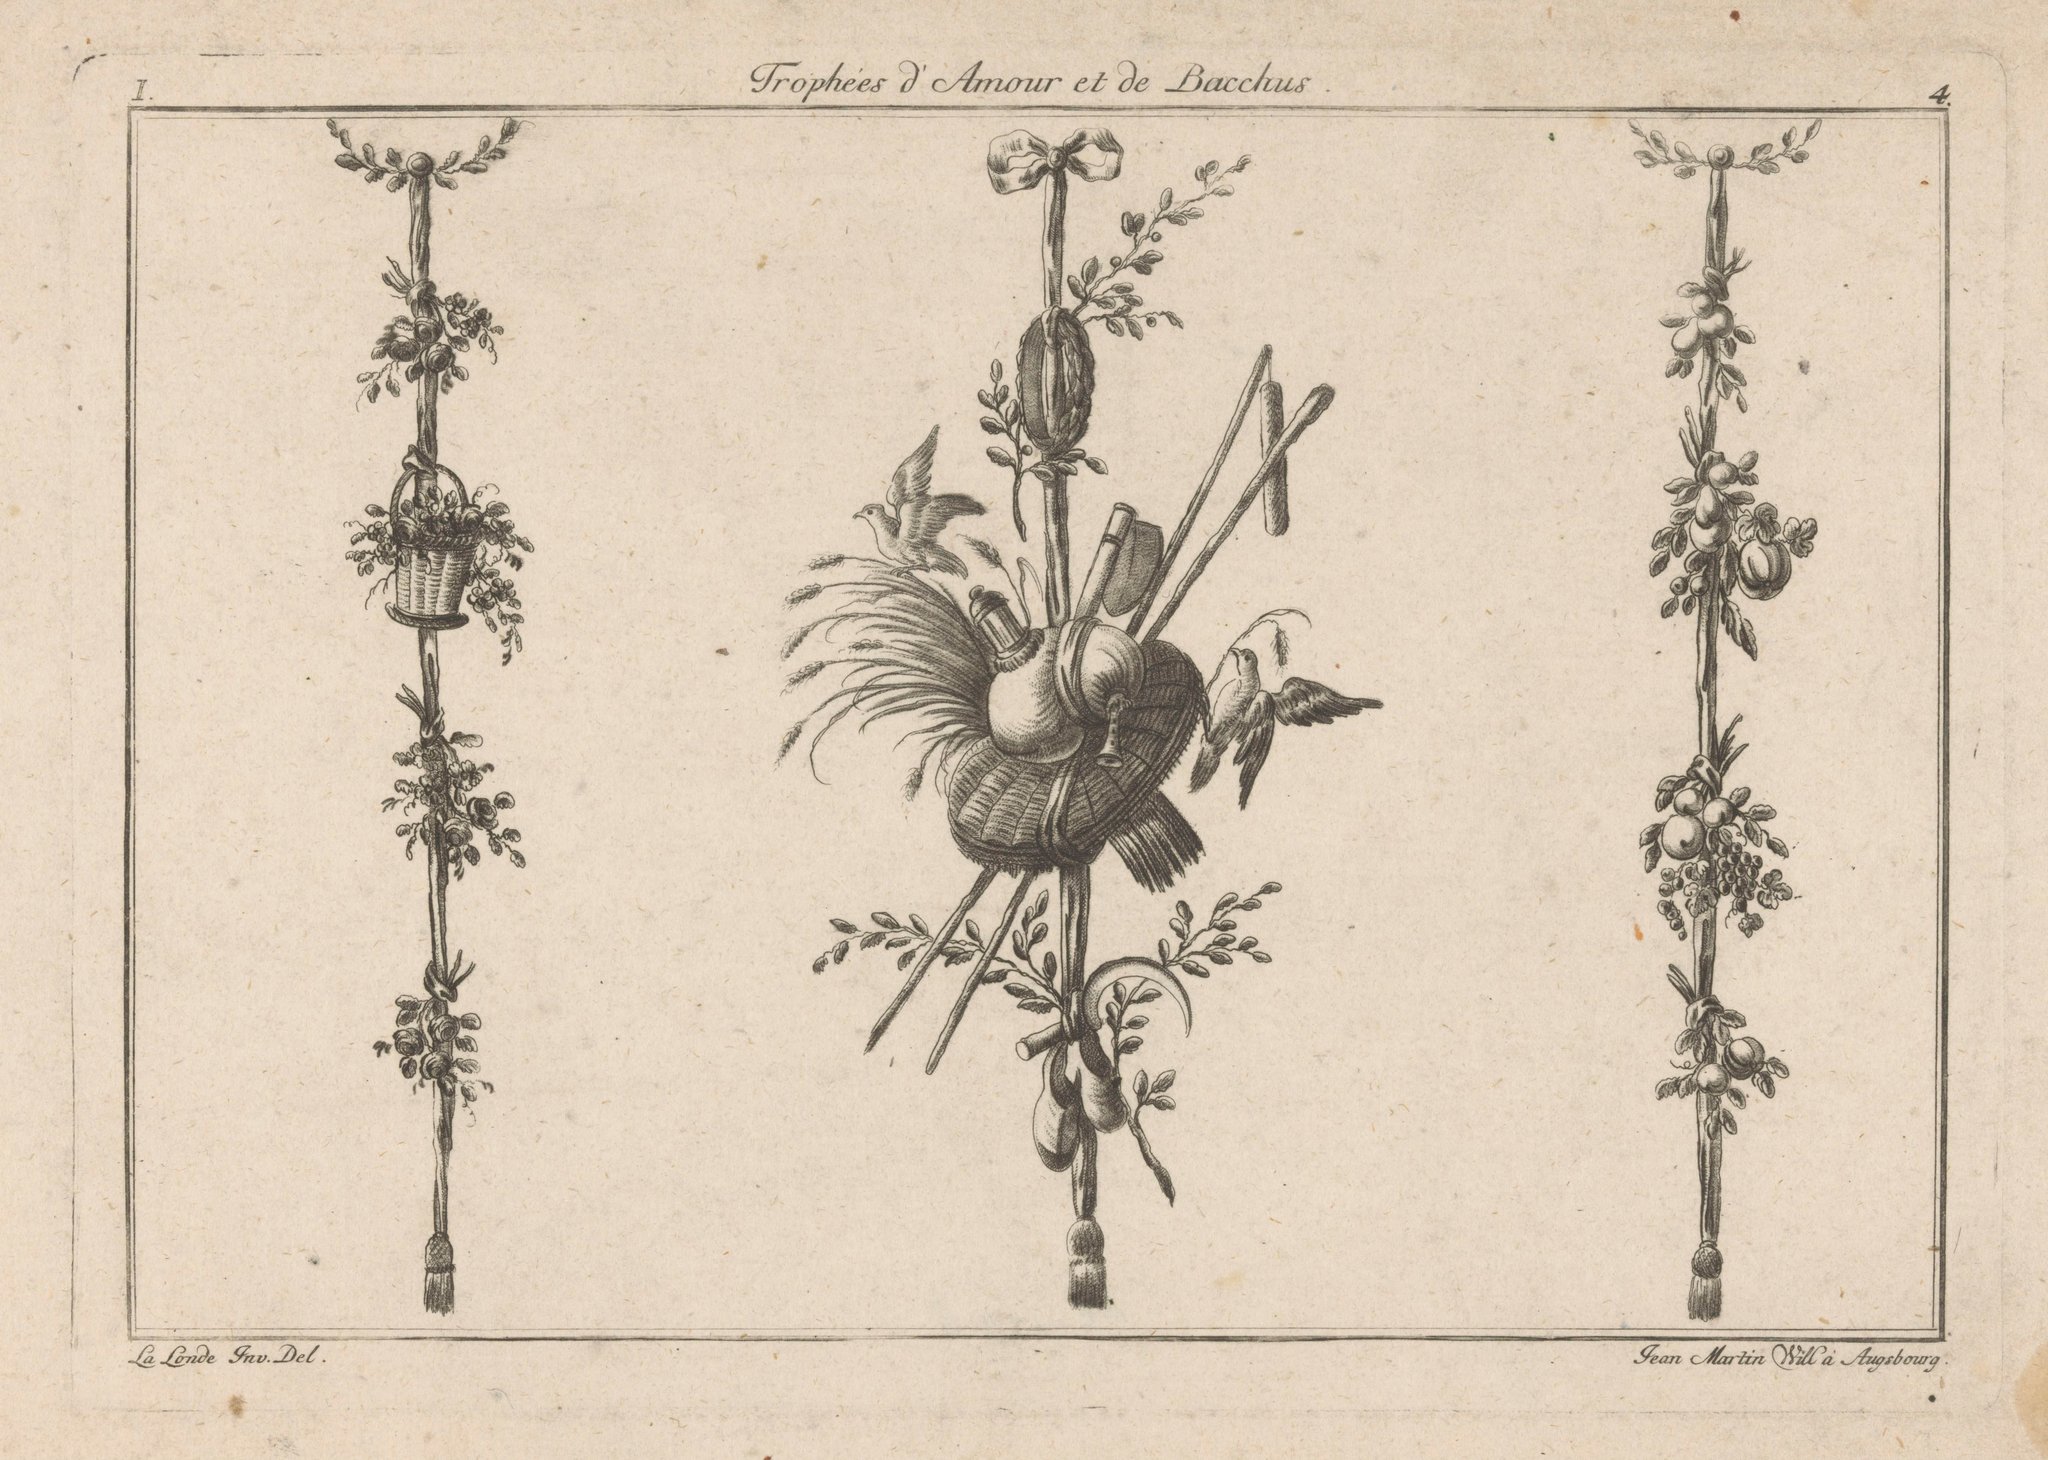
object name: ornament print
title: I Trophées d'Amour et de Bacchus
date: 1784-1806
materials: paper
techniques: aquatint, etching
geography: augsburg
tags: trophy, i.e.: decorative arrangement of symbolic or typical objects ~ ornament, other birds: dove, bagpipe, musette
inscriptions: collector's mark: Lugt 2760, collector's mark: Lugt 2228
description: Een trofee met een doedelzak, duiven, een krans, twee staven, een schep en een sikkel. Links en rechts twee slingers met bloemen en fruit.